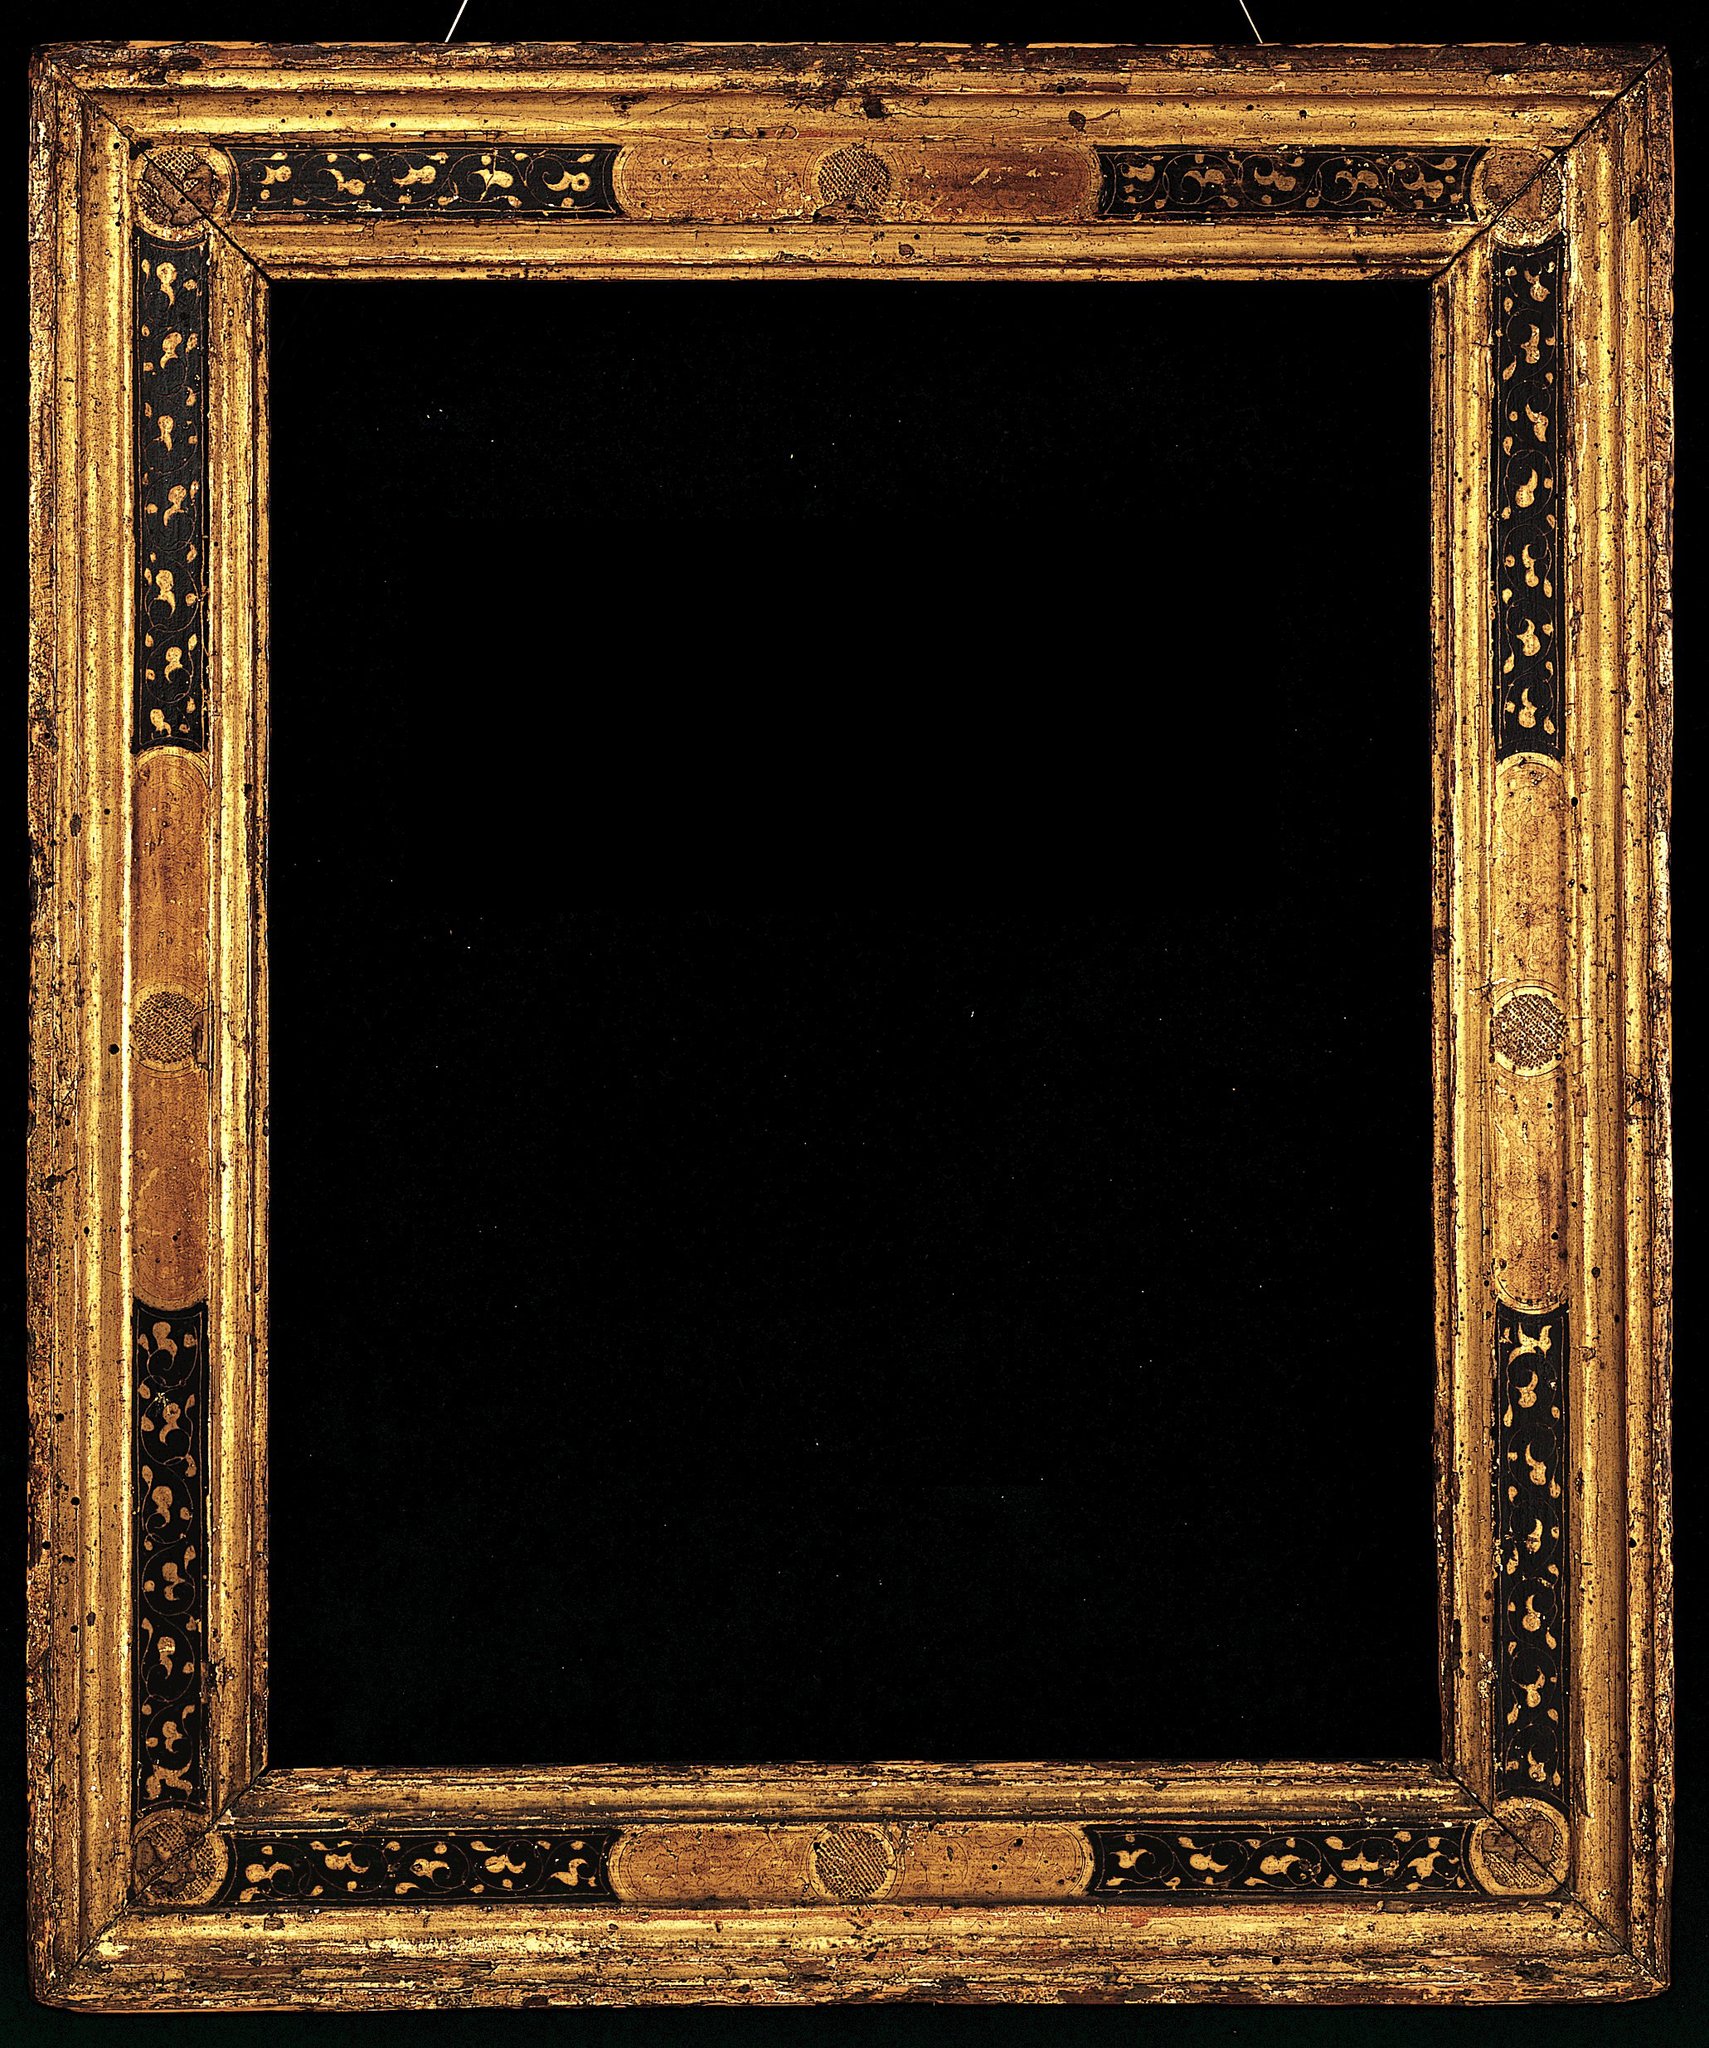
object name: frame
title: Cassetta frame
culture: italian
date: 1500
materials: wood